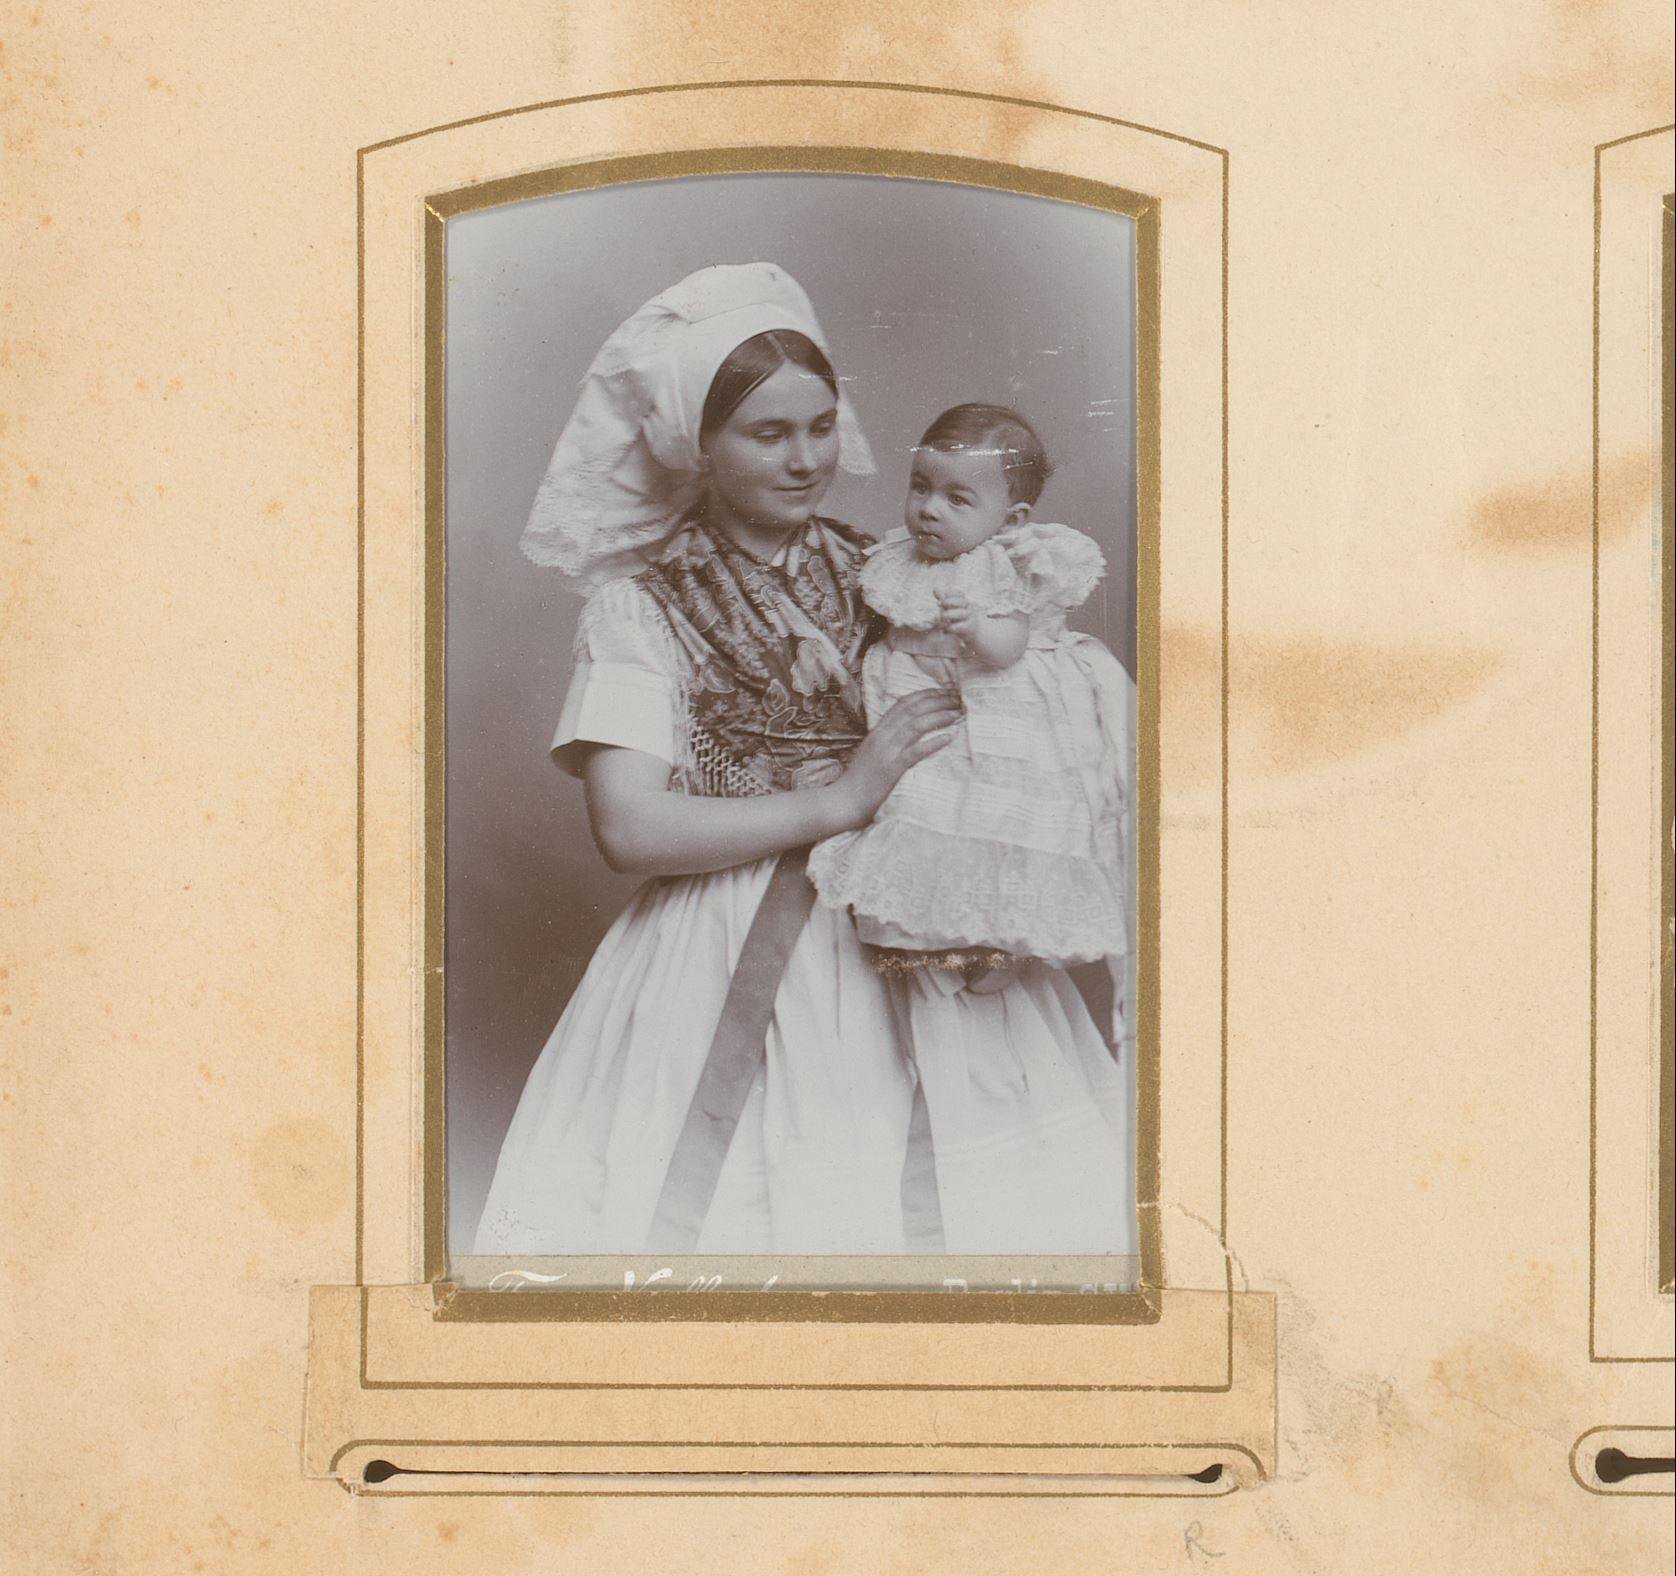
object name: album leaf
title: Portret van een vrouw in klederdracht met een baby op de arm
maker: franz kullrich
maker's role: fotograaf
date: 1880-1920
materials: cardboard, photographic support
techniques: collodion silver print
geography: berlin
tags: historical persons - bb - woman, folk costume, regional costume, infant, baby ~ the ages of man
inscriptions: inscription: ‘Fernsprecher Amt 6./ No. 1834./ Franz Kullrich/ Berlin, S.W./ Königgrätzer Str. 109./ Atelier im Garten Parterre.’